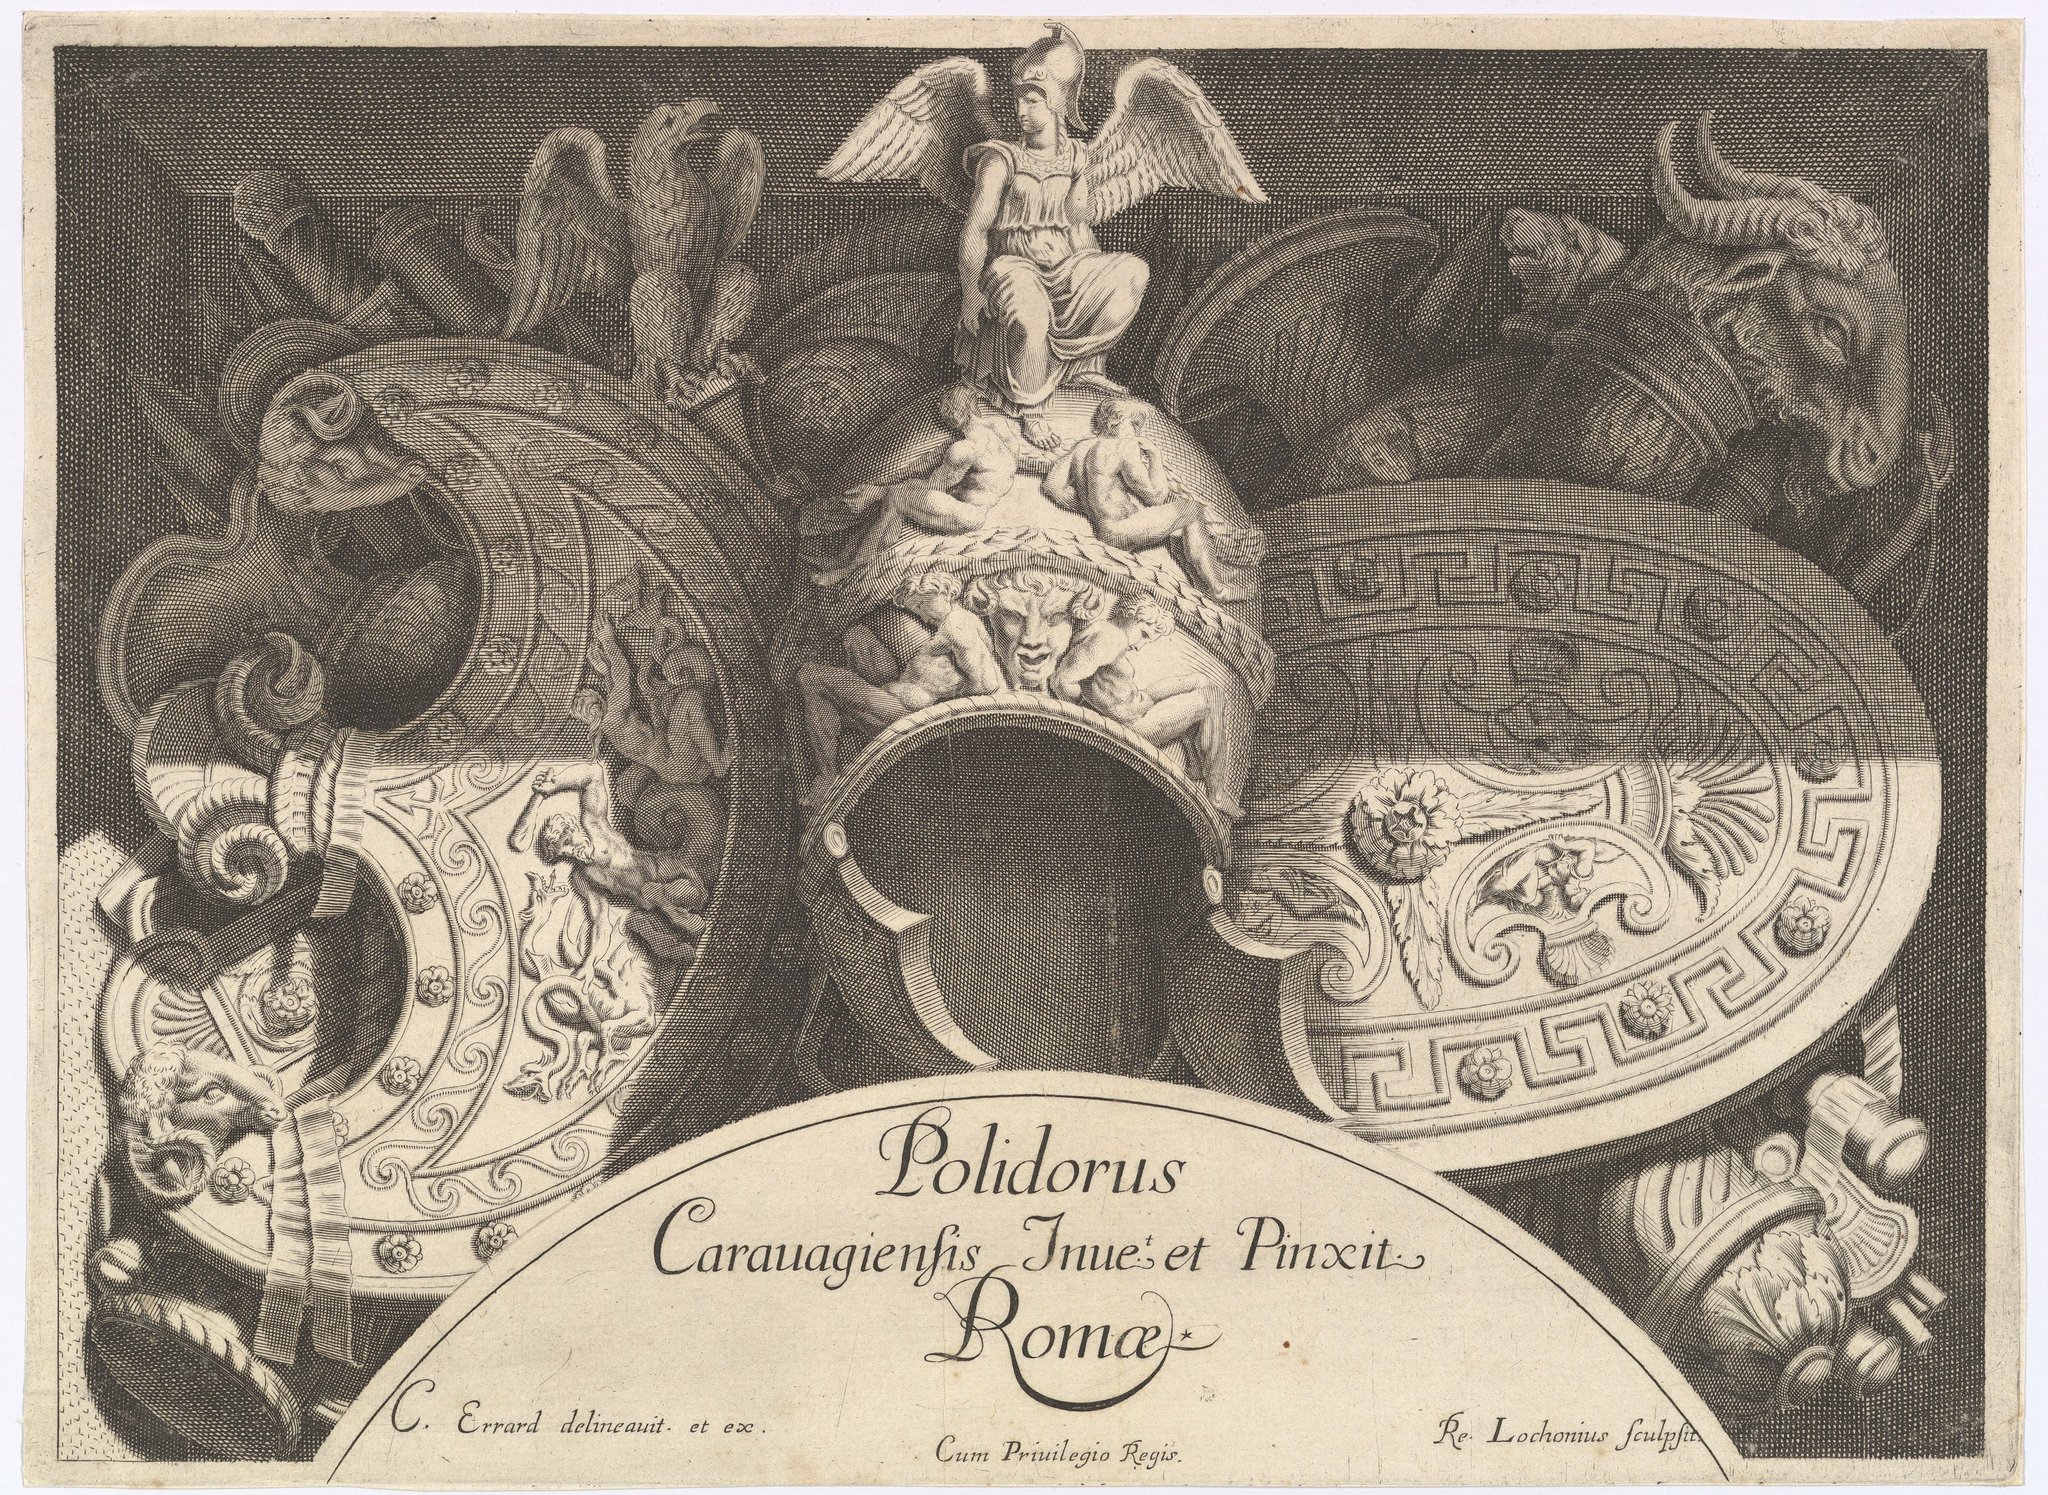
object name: print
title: Plate from "Divers Trophées" (Weapon Trophies after the Façade of Palazzo Milesi in Rome)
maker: polidoro da caravaggio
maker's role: artist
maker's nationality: italian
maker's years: 1494-1548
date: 1651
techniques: engraving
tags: animals,helmets,trophies